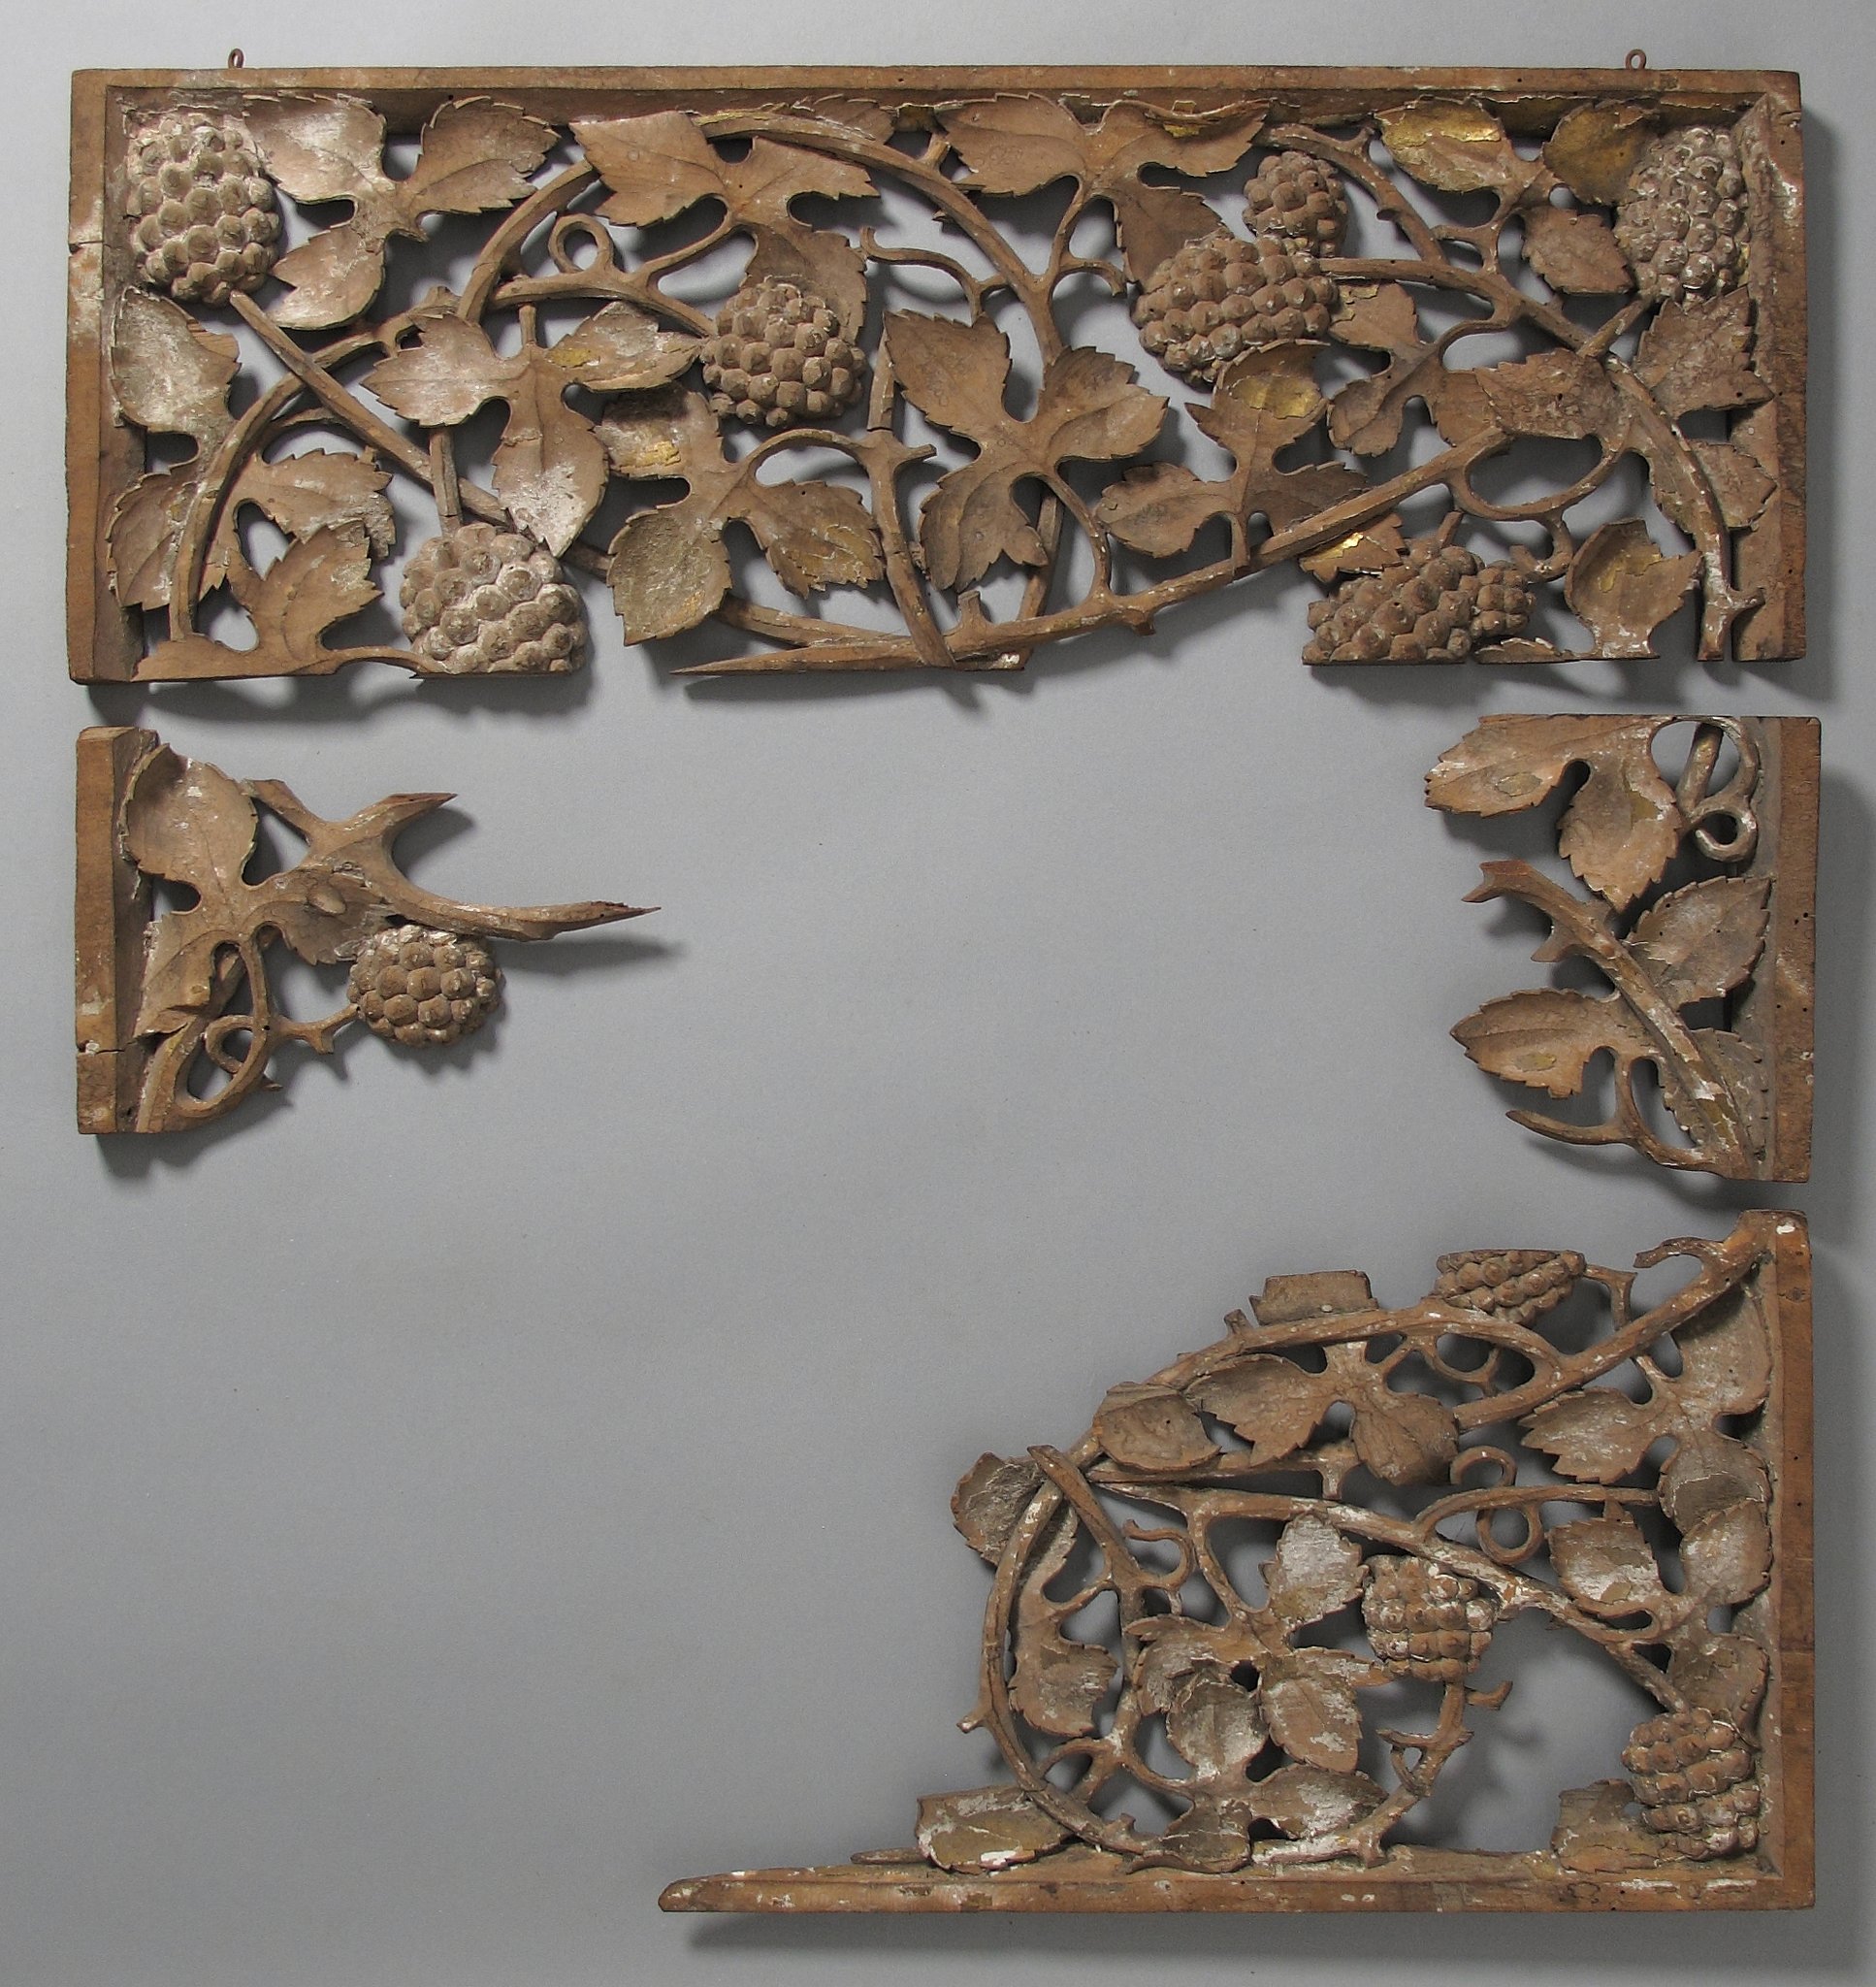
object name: panel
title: Panels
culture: swiss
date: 1401-1500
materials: wood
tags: fruit